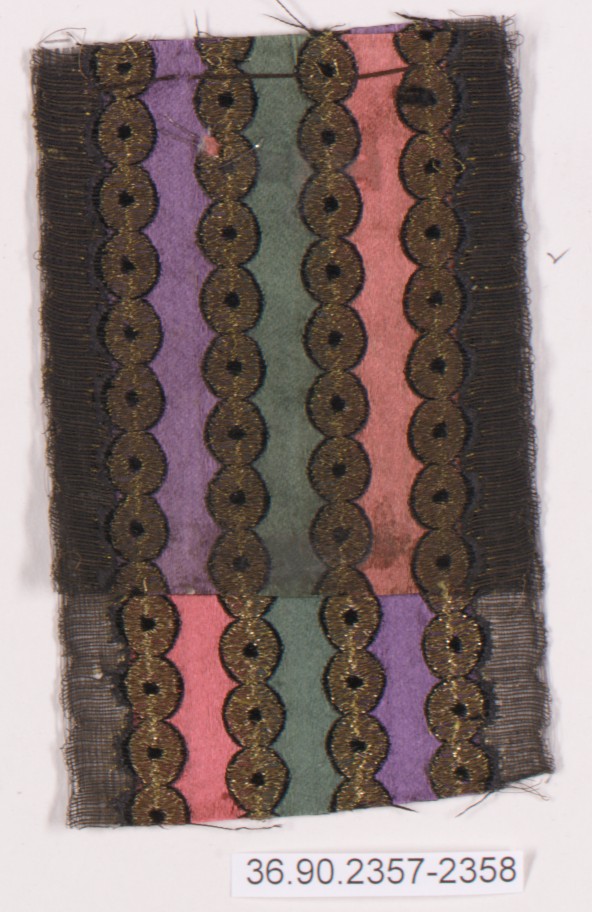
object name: ribbon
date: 1801-1900